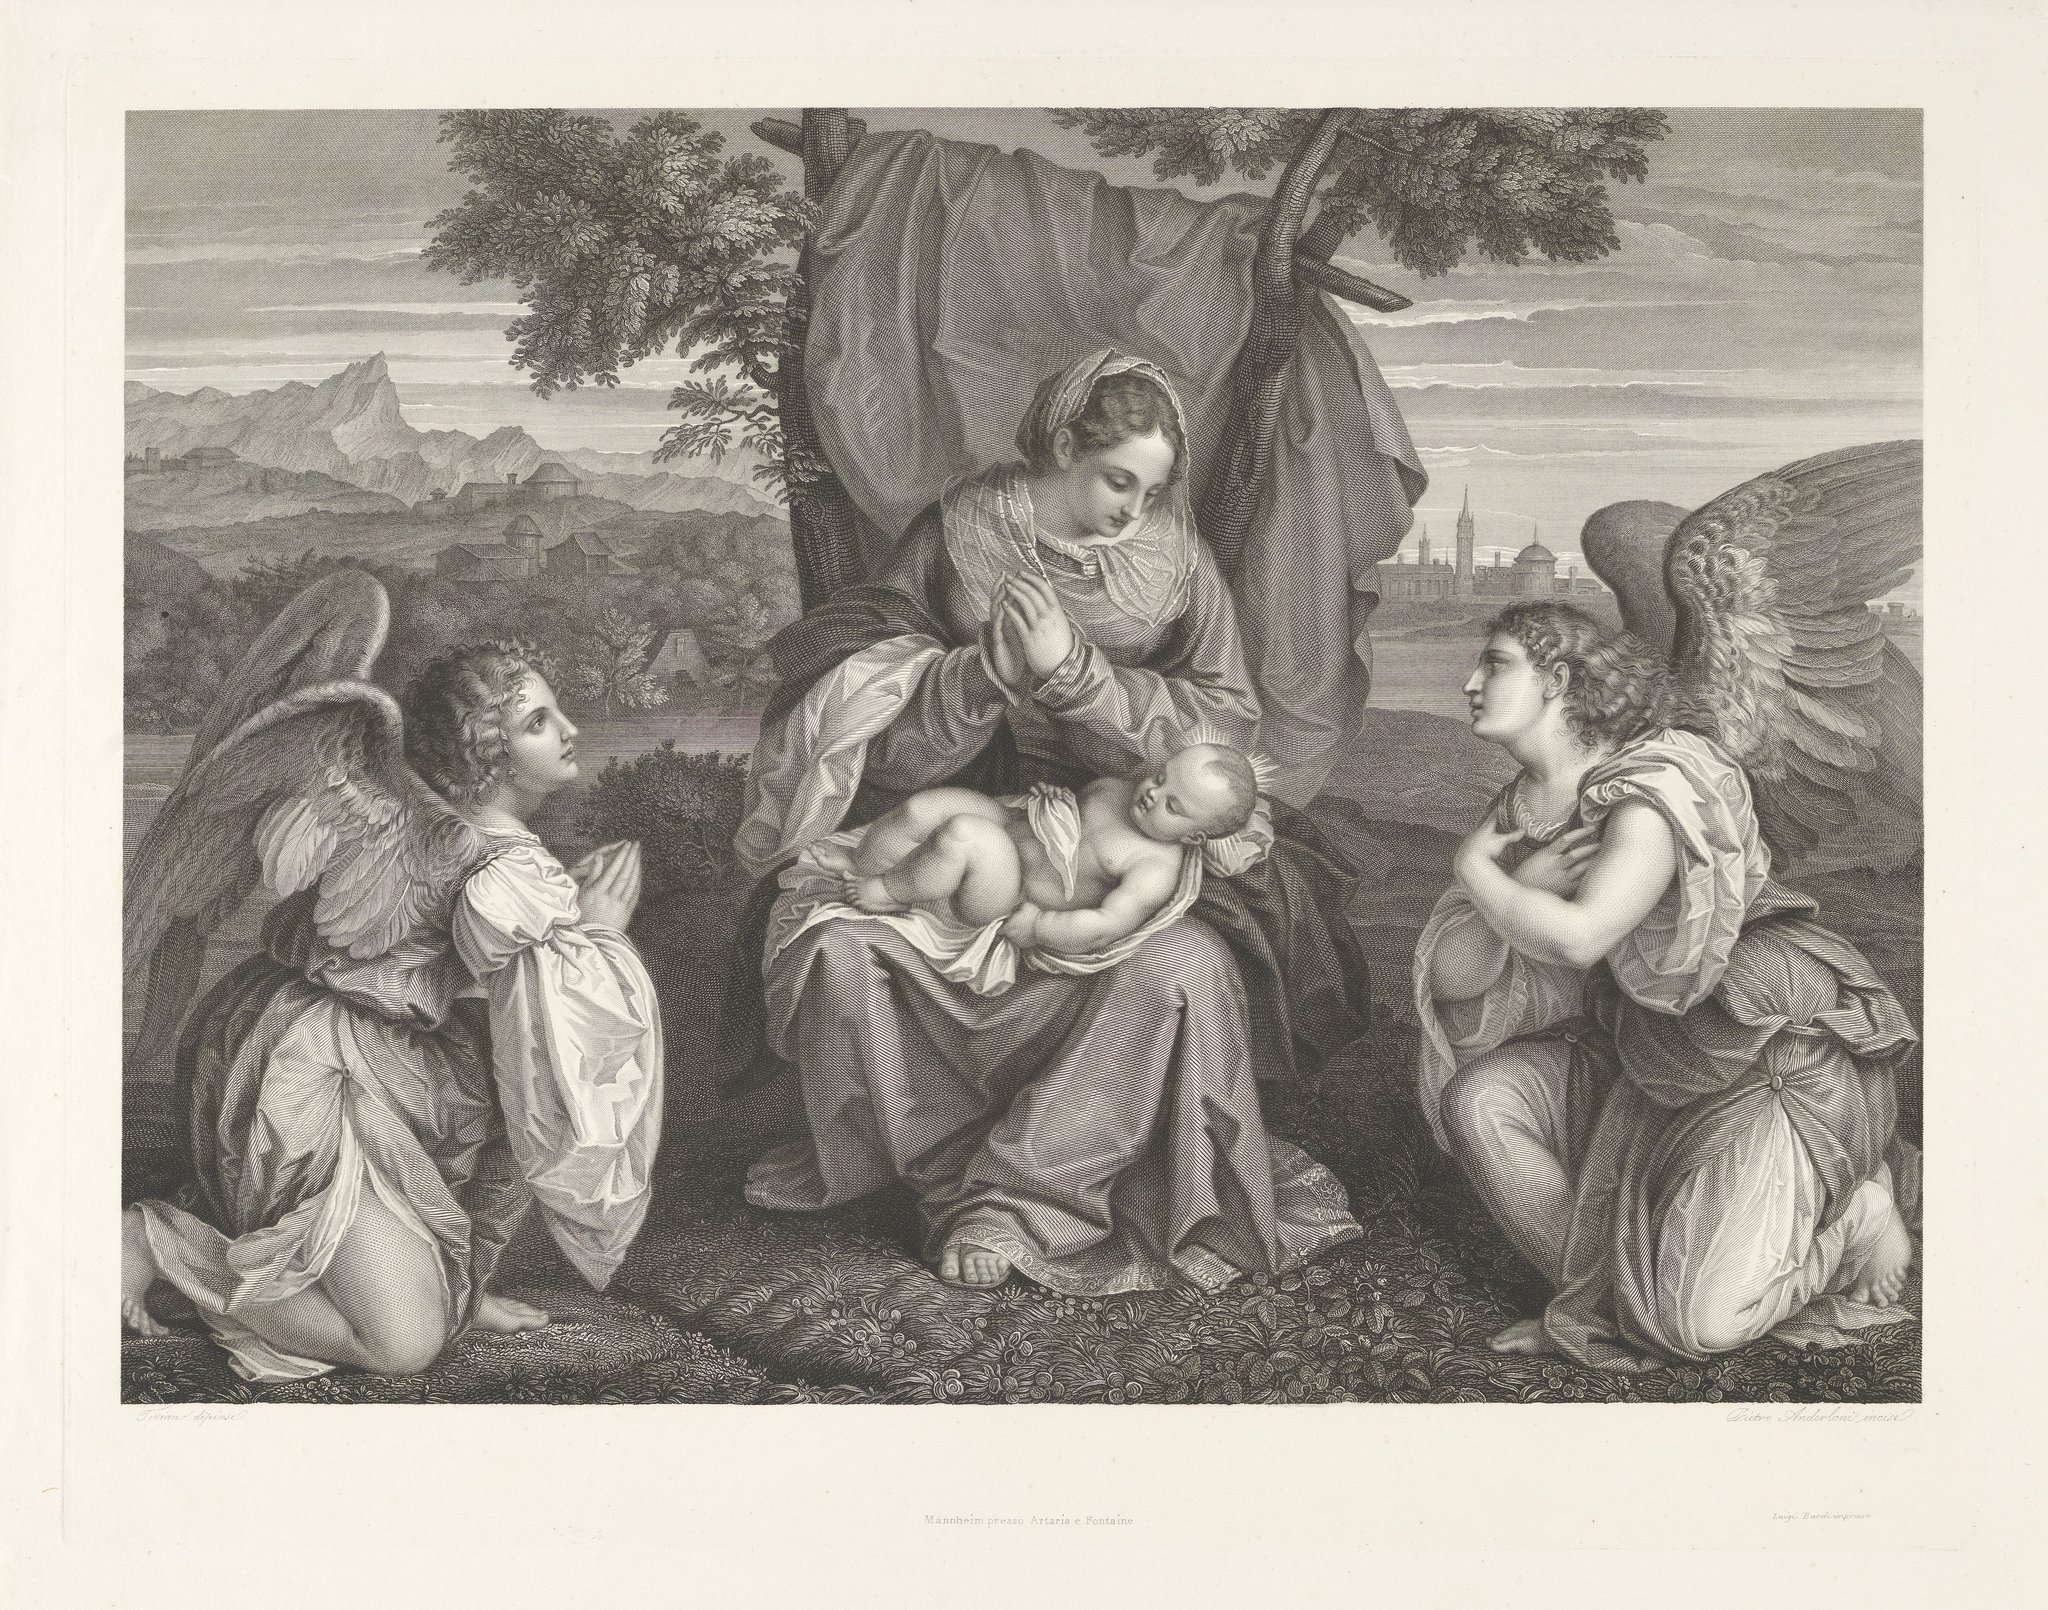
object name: print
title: Maria met Kind in landschap tussen twee engelen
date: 1819-1825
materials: paper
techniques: engraving, etching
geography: italy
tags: madonna: i.e. mary with the christ-child, angels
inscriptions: collector's mark: Lugt 12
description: Maria zit met het Christuskind op schoot in een landschap, tussen twee knielende engelen, voor een boom met daarin een doek gespannen.